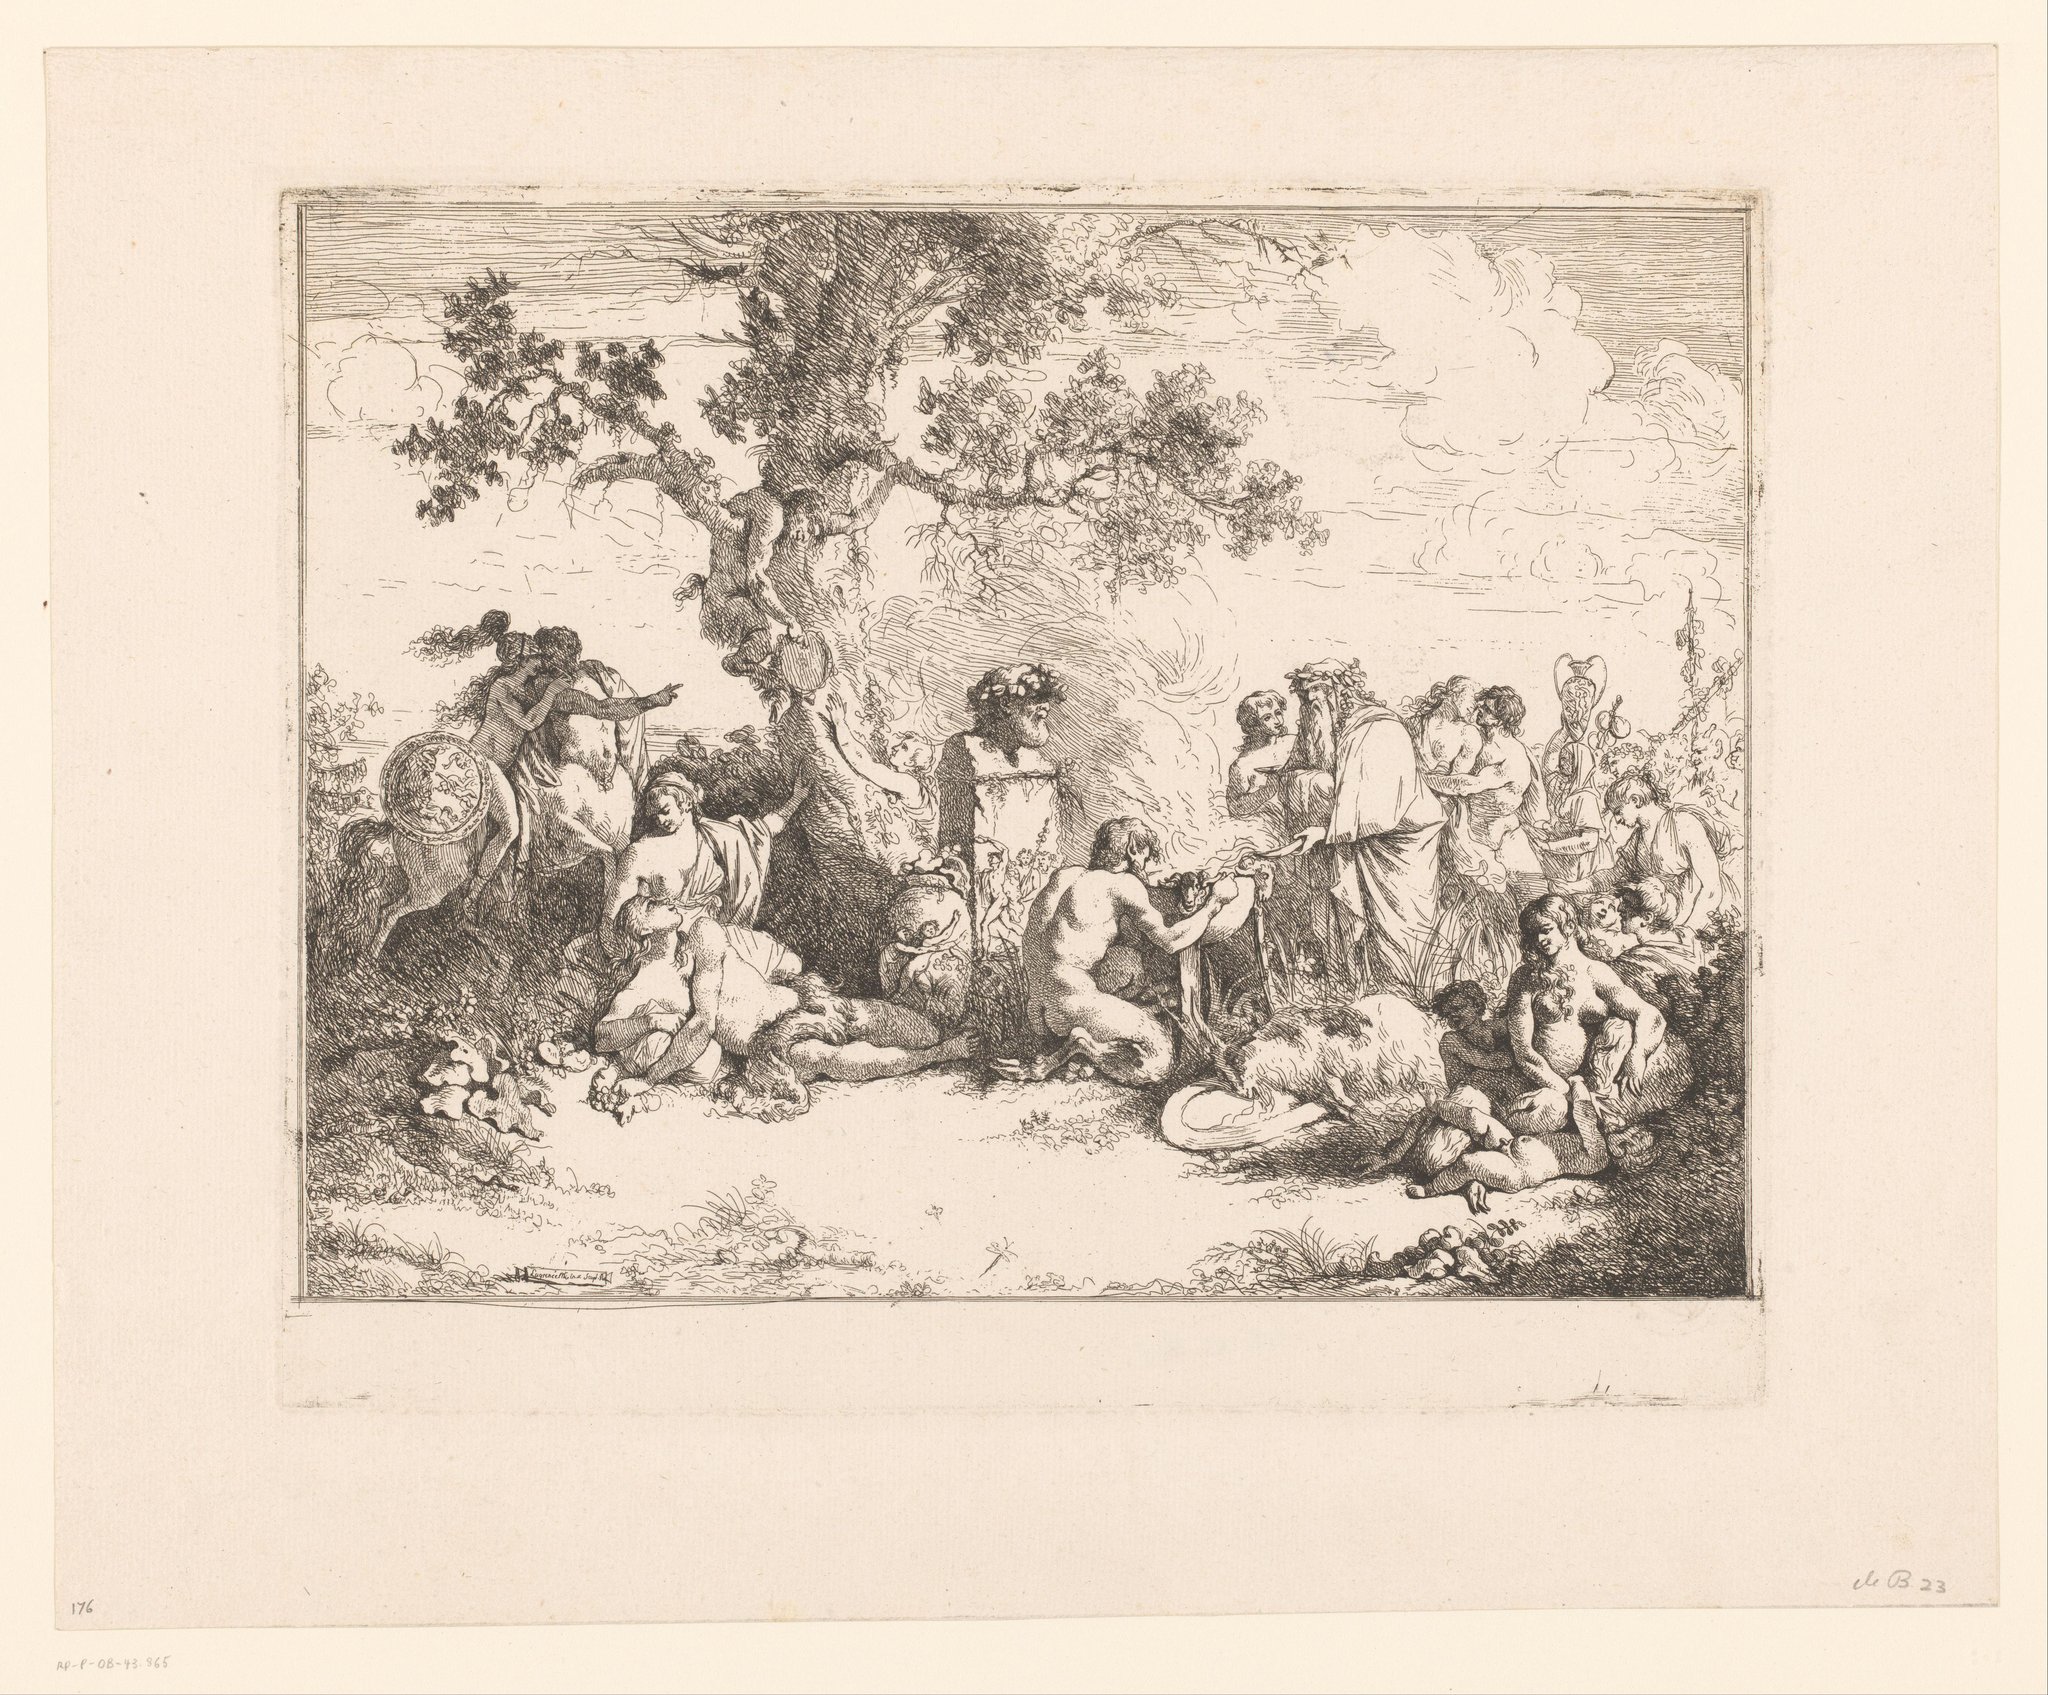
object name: print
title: Offer aan Pan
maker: jean jacques ii lagrenée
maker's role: print maker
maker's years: 1739-1821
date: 1749-1821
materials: paper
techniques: etching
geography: sint-petersburg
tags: (story of) pan, sacrifice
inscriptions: collector's mark: Lugt 240